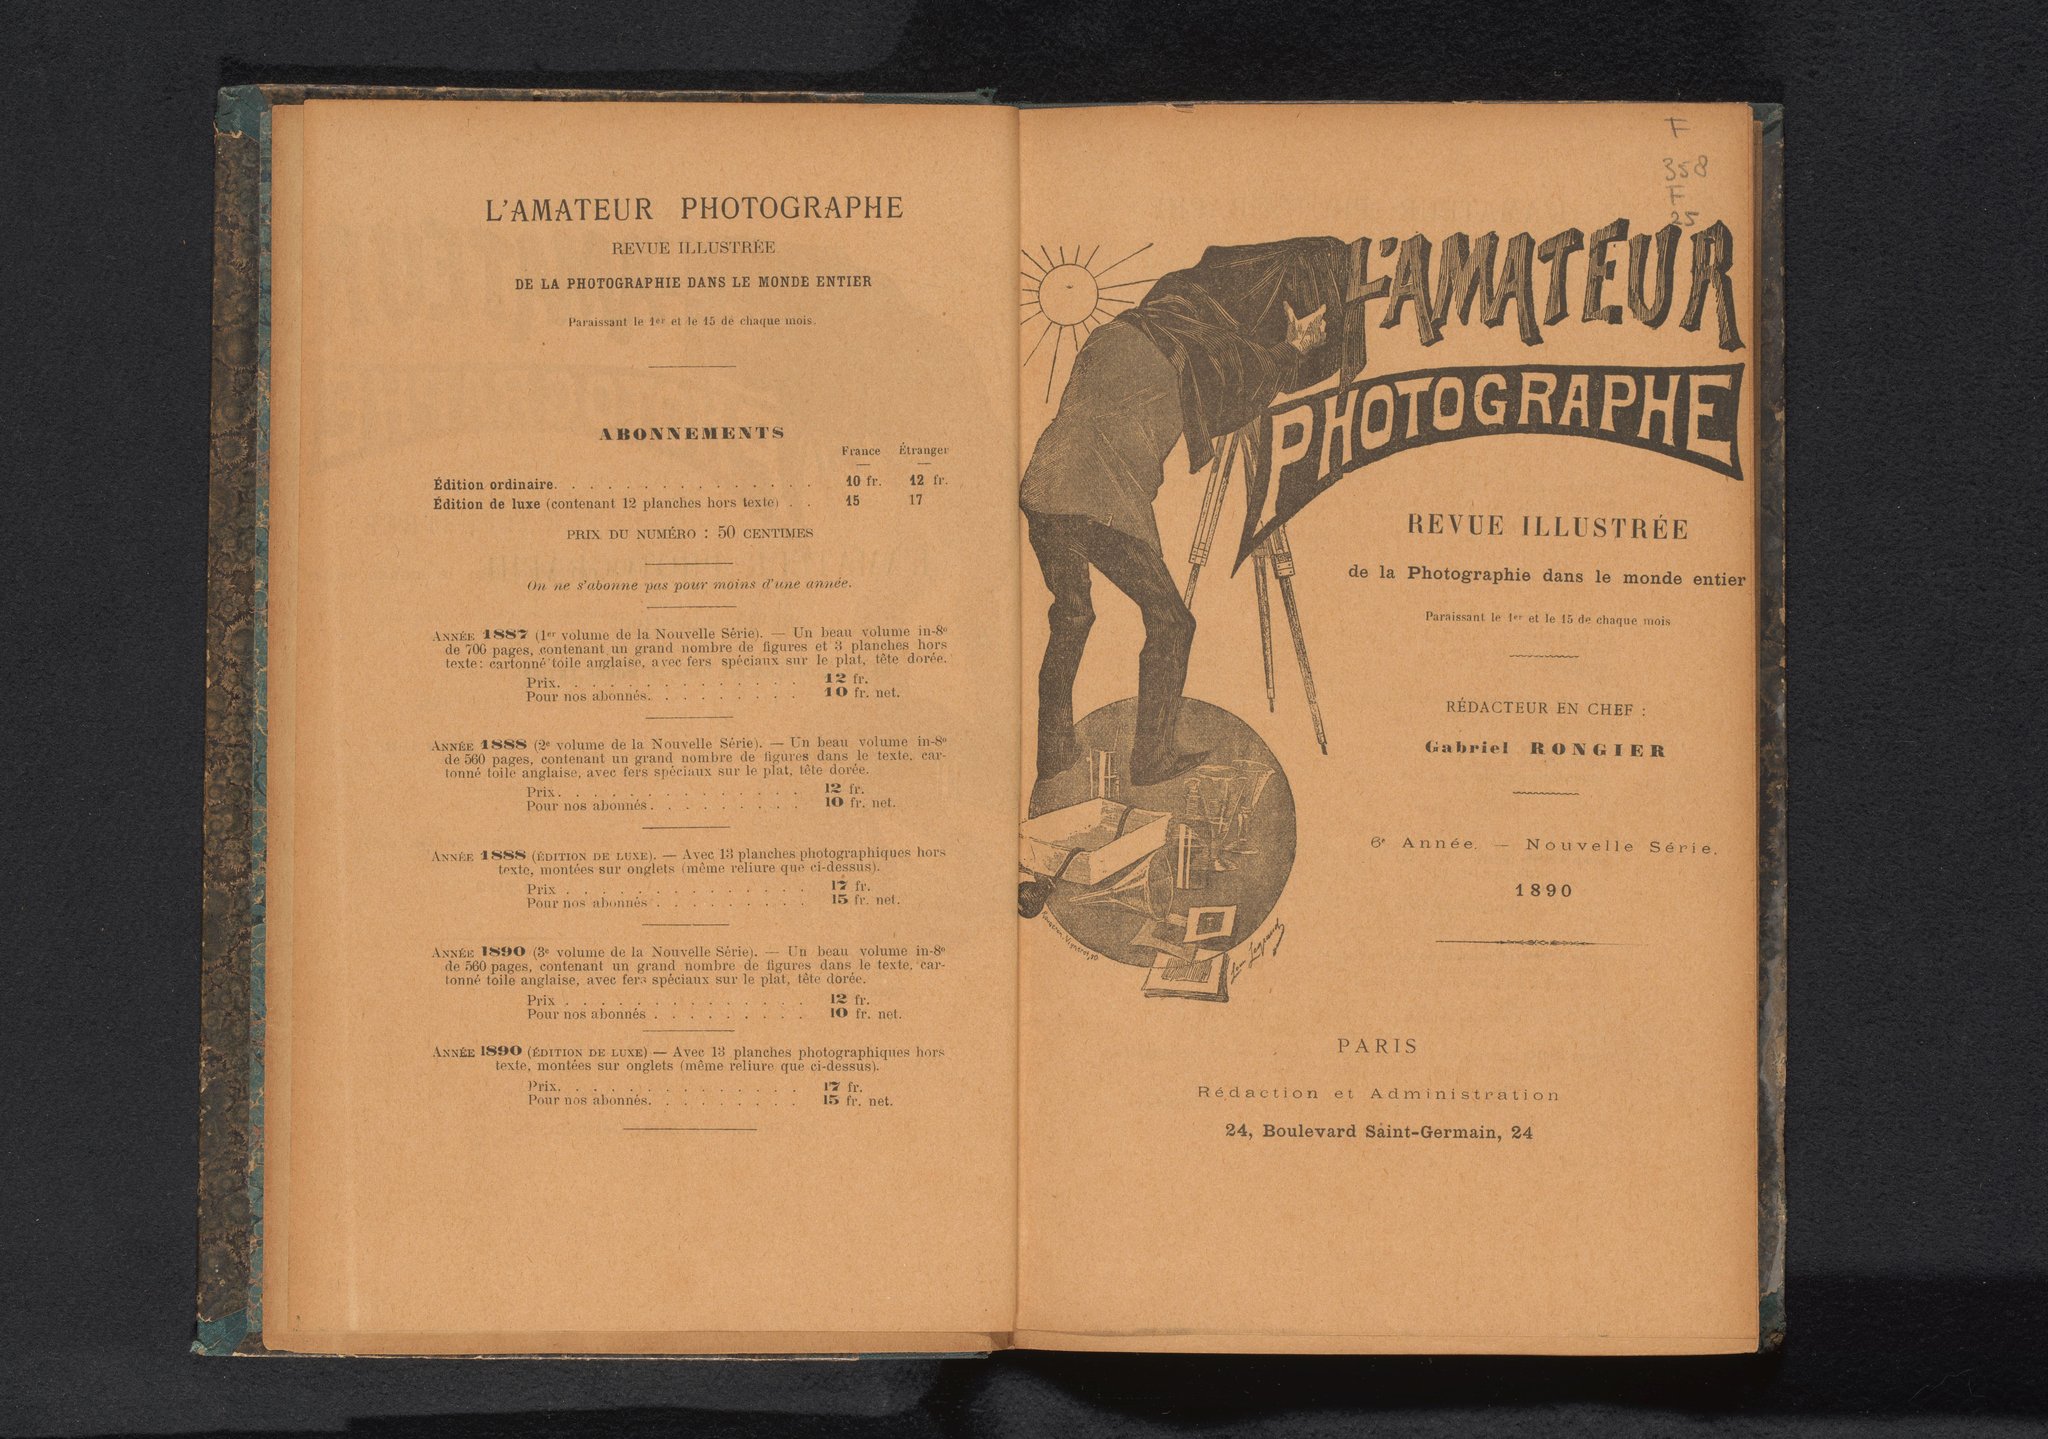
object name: magazine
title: L'amateur photographe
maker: gabriel rongier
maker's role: redacteur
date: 1890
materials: cardboard, linen, paper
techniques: photograph, printing, marbling, woodburytype